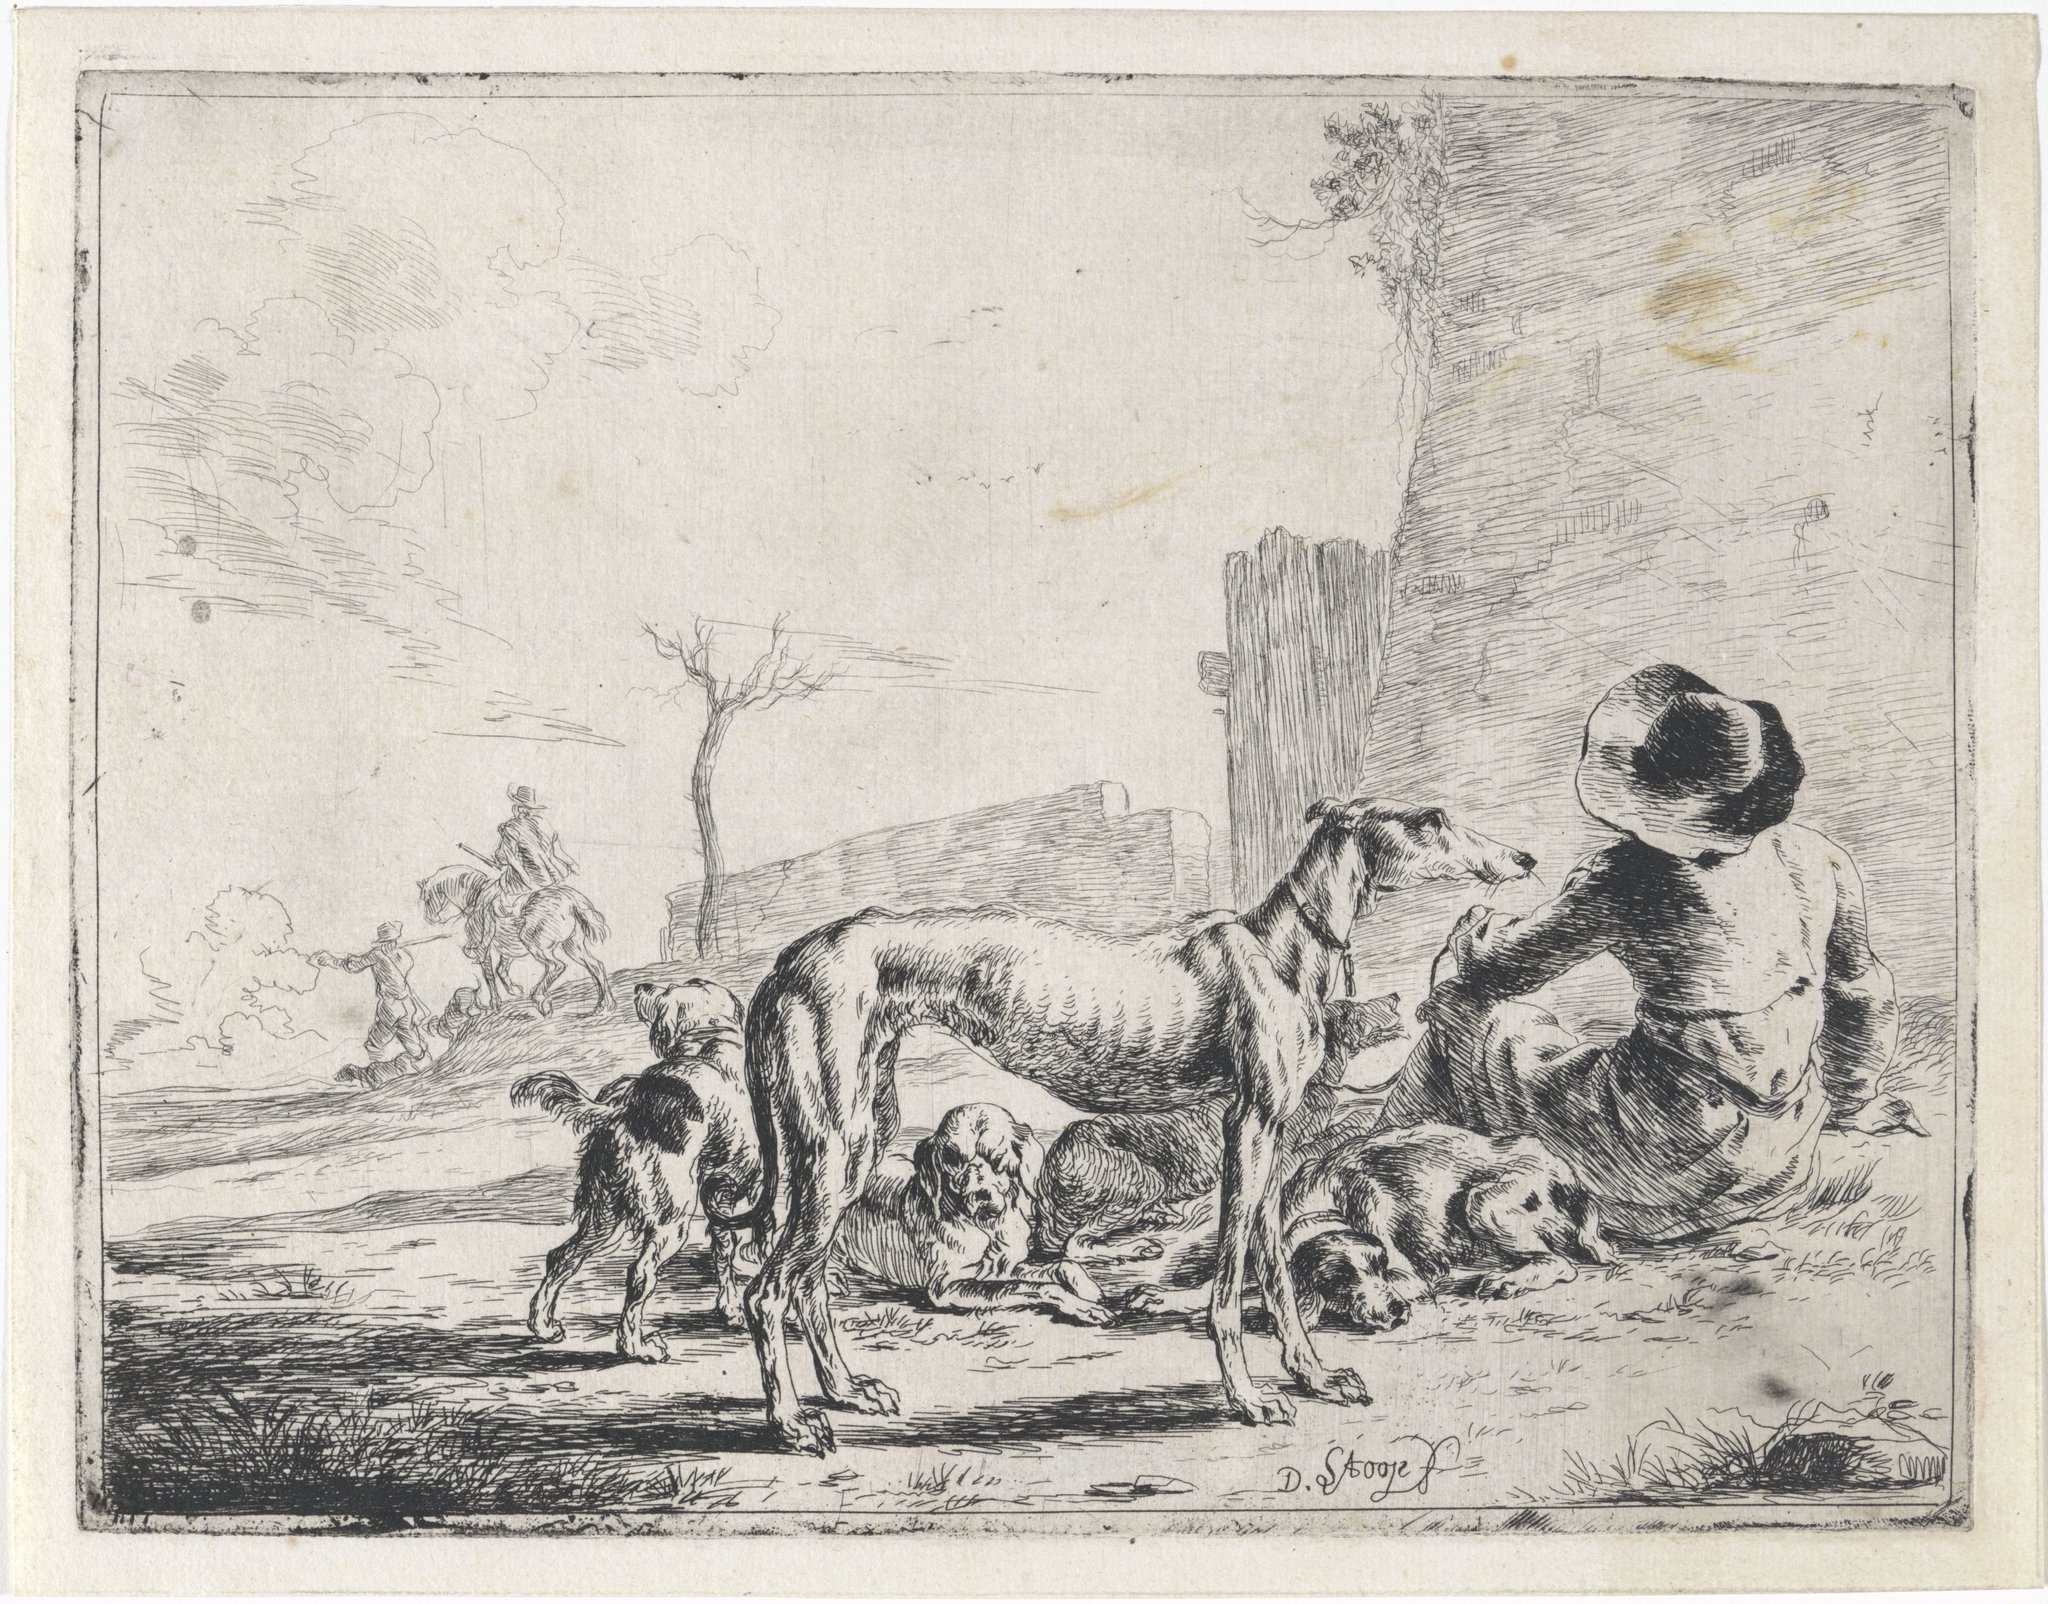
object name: print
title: Man met vijf honden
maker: dirk stoop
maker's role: draughtsman, painter, print maker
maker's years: 1615-1686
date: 1651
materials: paper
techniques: etching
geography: utrecht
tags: horse, sitting on the ground, dog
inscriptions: collector's mark: Lugt 240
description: Een man, op de rug gezien, zit op de grond te midden van vijf honden. Links een ruiter en een man te voet met honden.